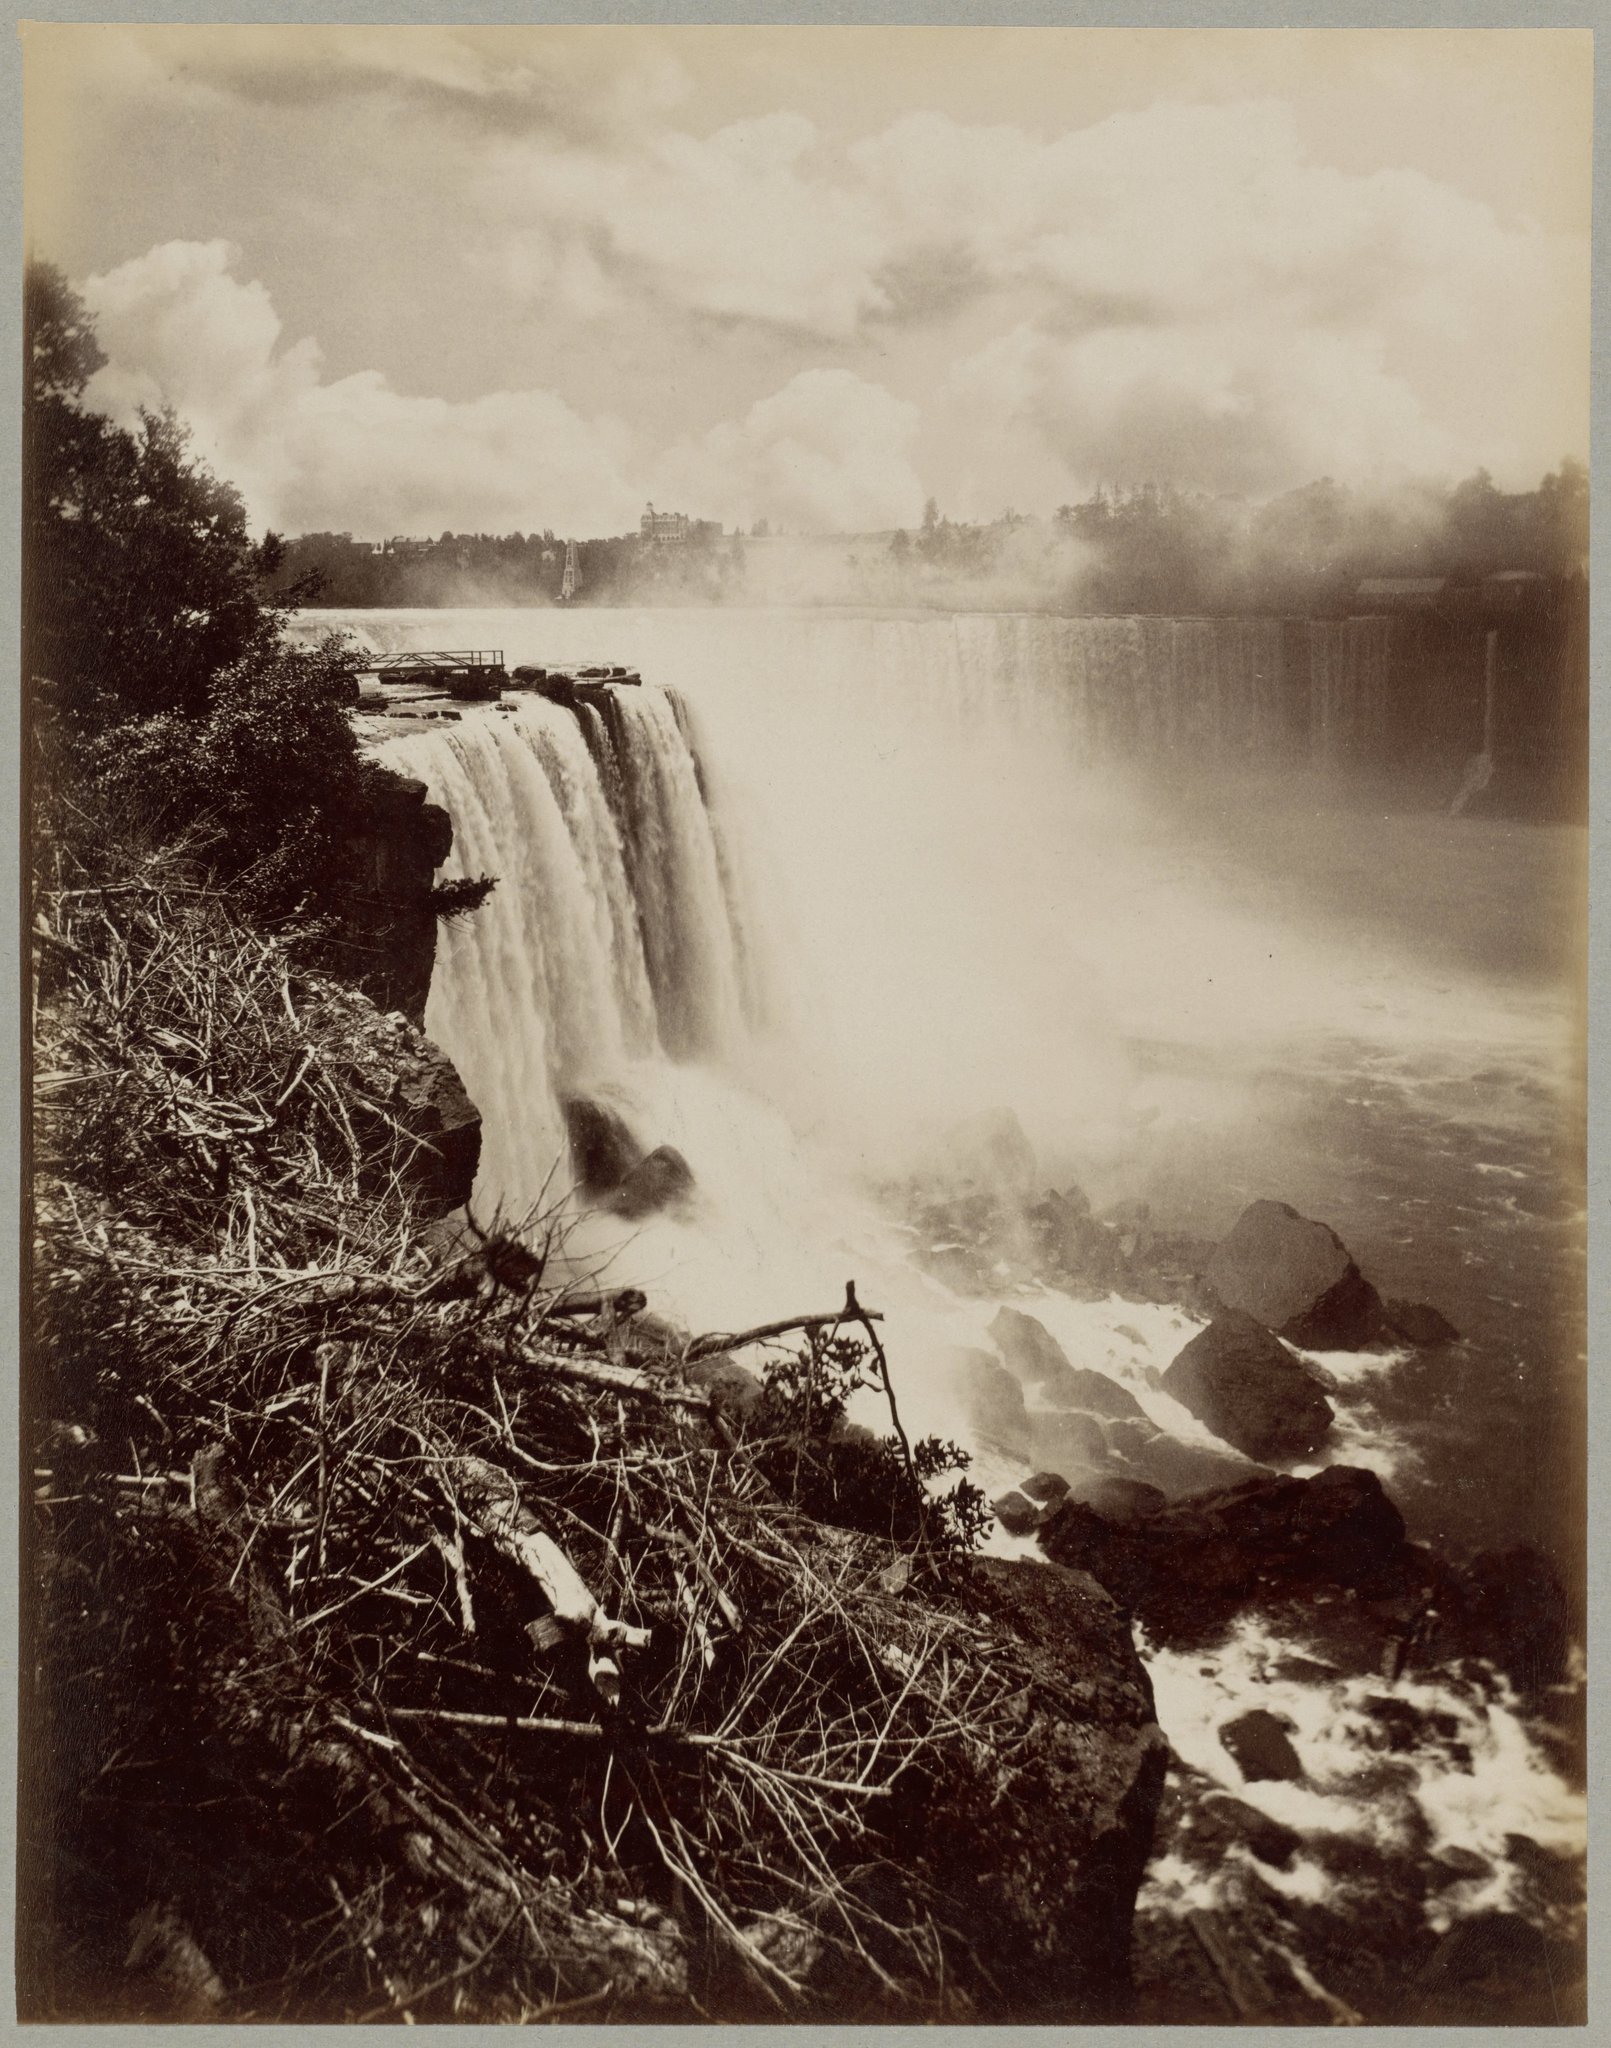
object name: photograph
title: Gezicht op de Niagarawatervallen met op de voorgrond rotsblokken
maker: Anonymous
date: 1880-1900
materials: cardboard, paper, photographic support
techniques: albumen print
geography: niagara falls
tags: waterfall